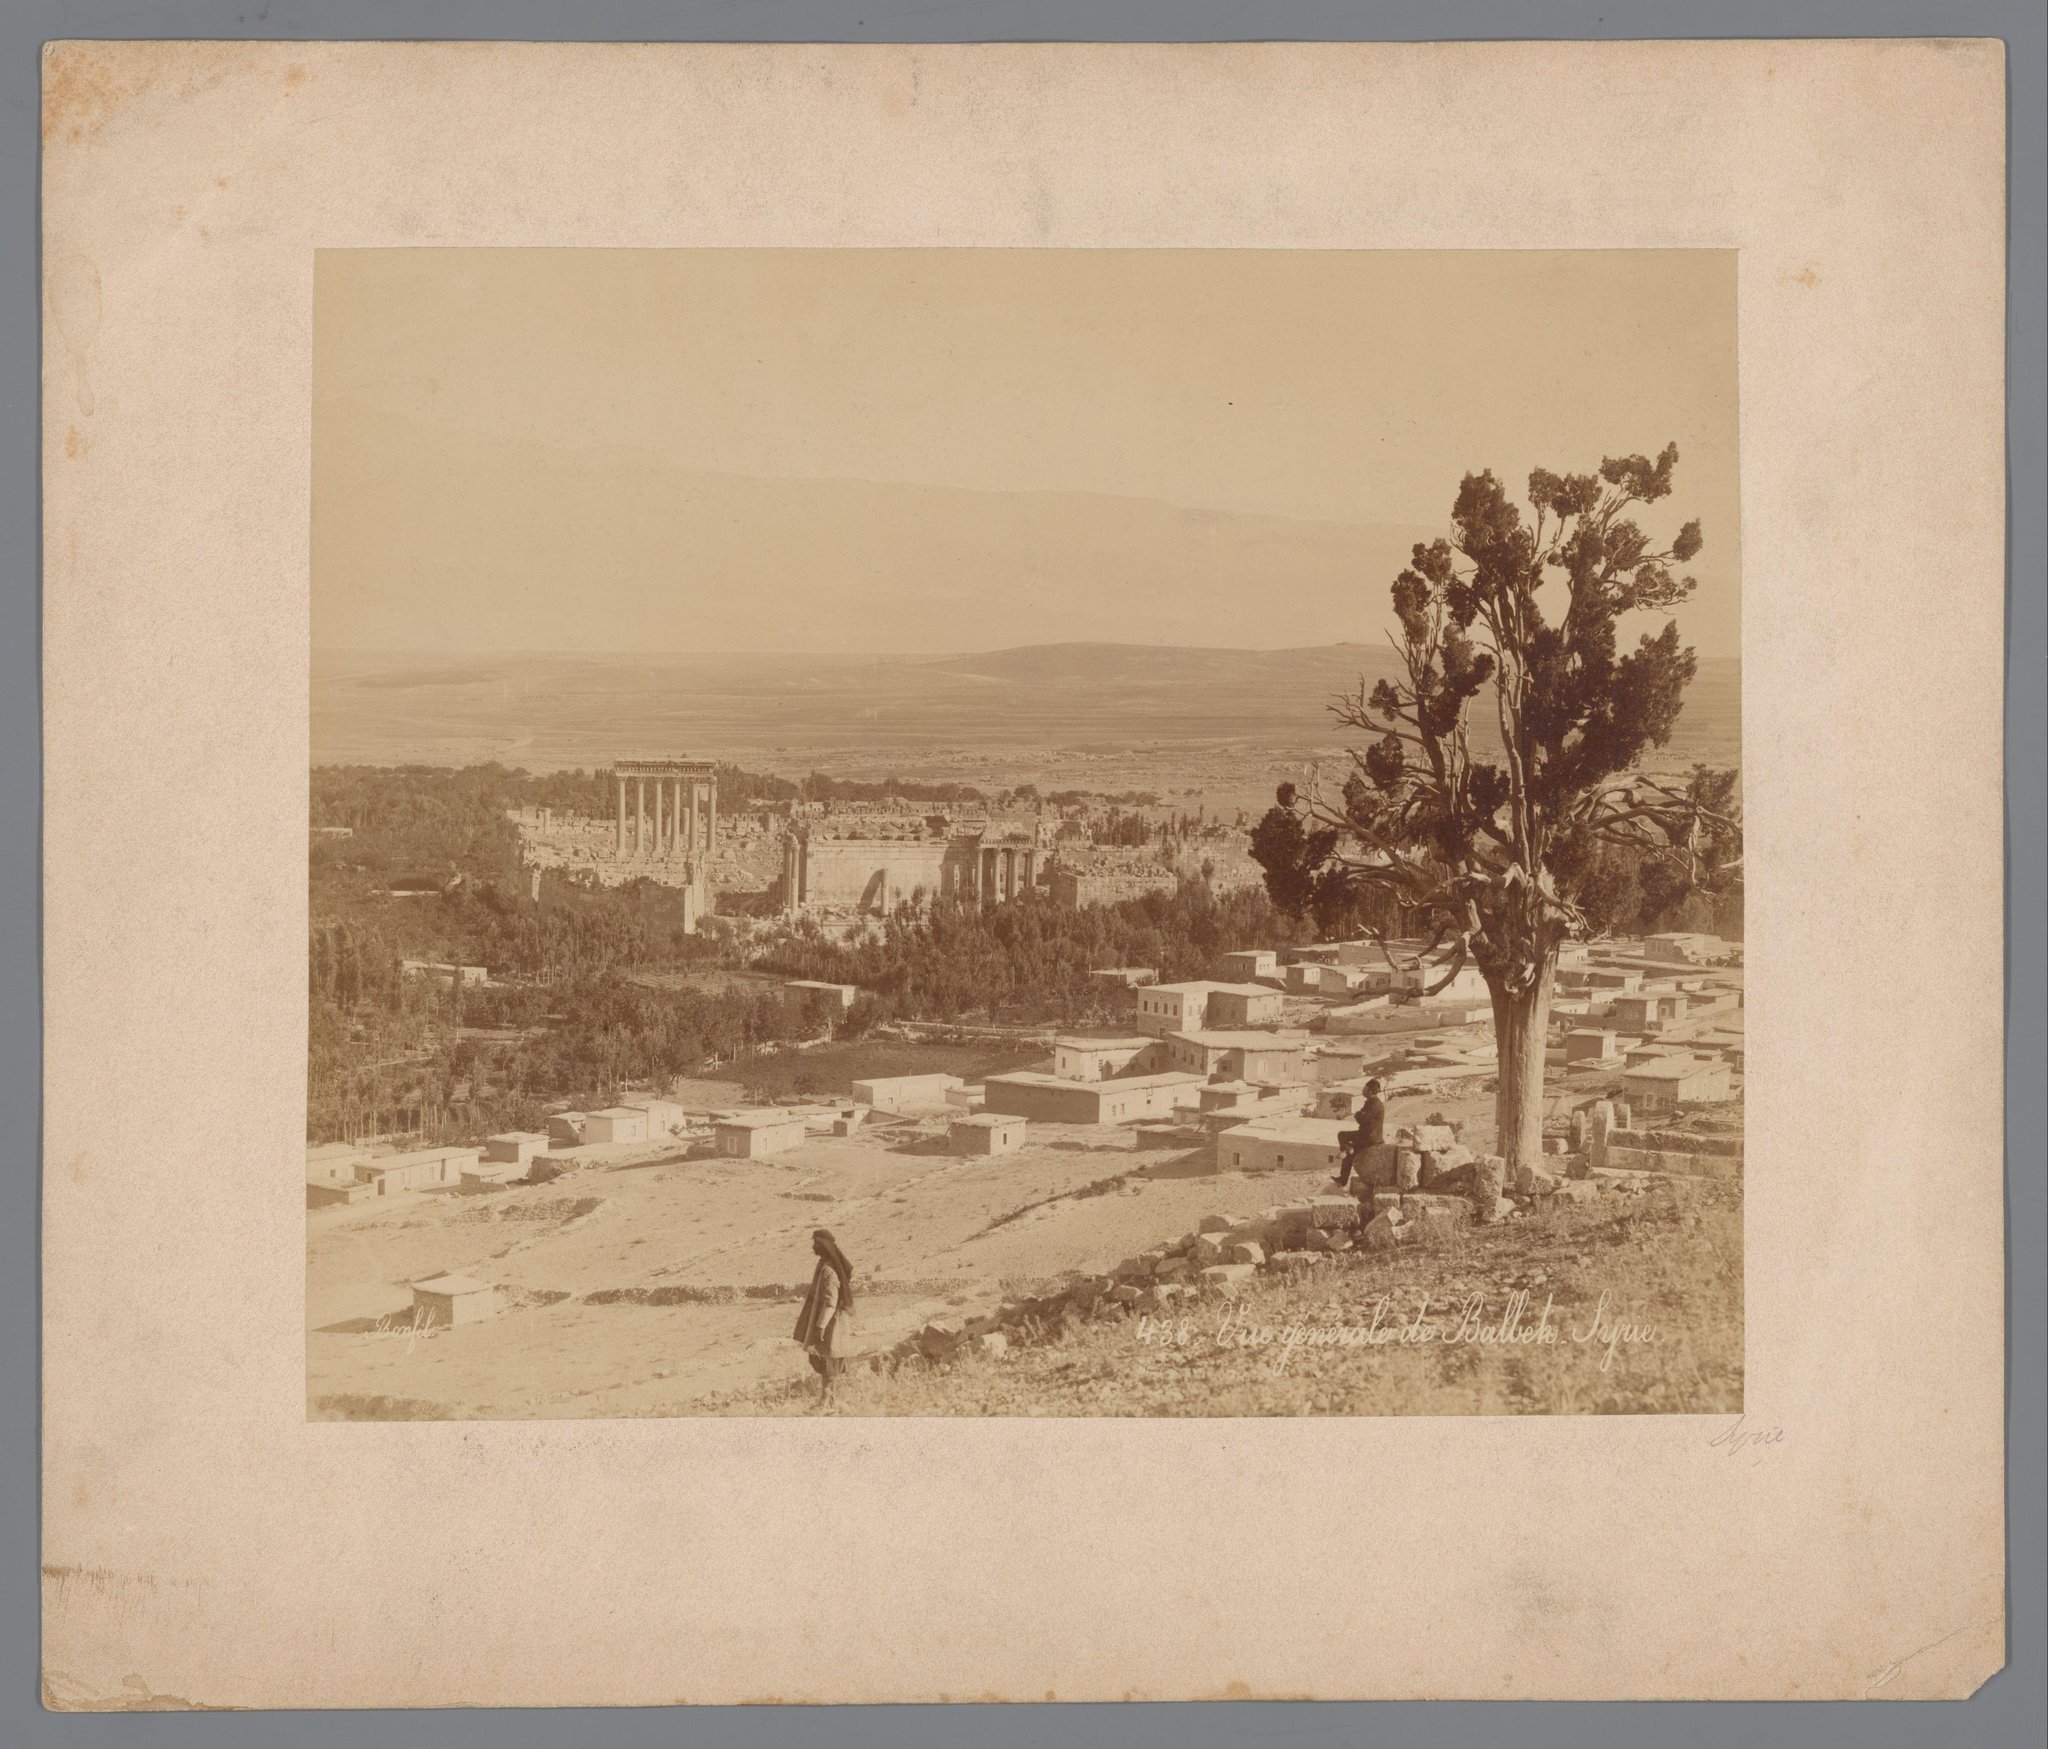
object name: photograph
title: Gezicht op Baalbek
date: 1875-1900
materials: cardboard, photographic support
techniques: albumen print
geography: baalbek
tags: trees, landscape with ruins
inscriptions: collector's mark: Lugt 3937, number: ‘438’, name: ‘J. A. G. DE LEUR Représentant Huigenspark, 40b. DEN HAAG.’